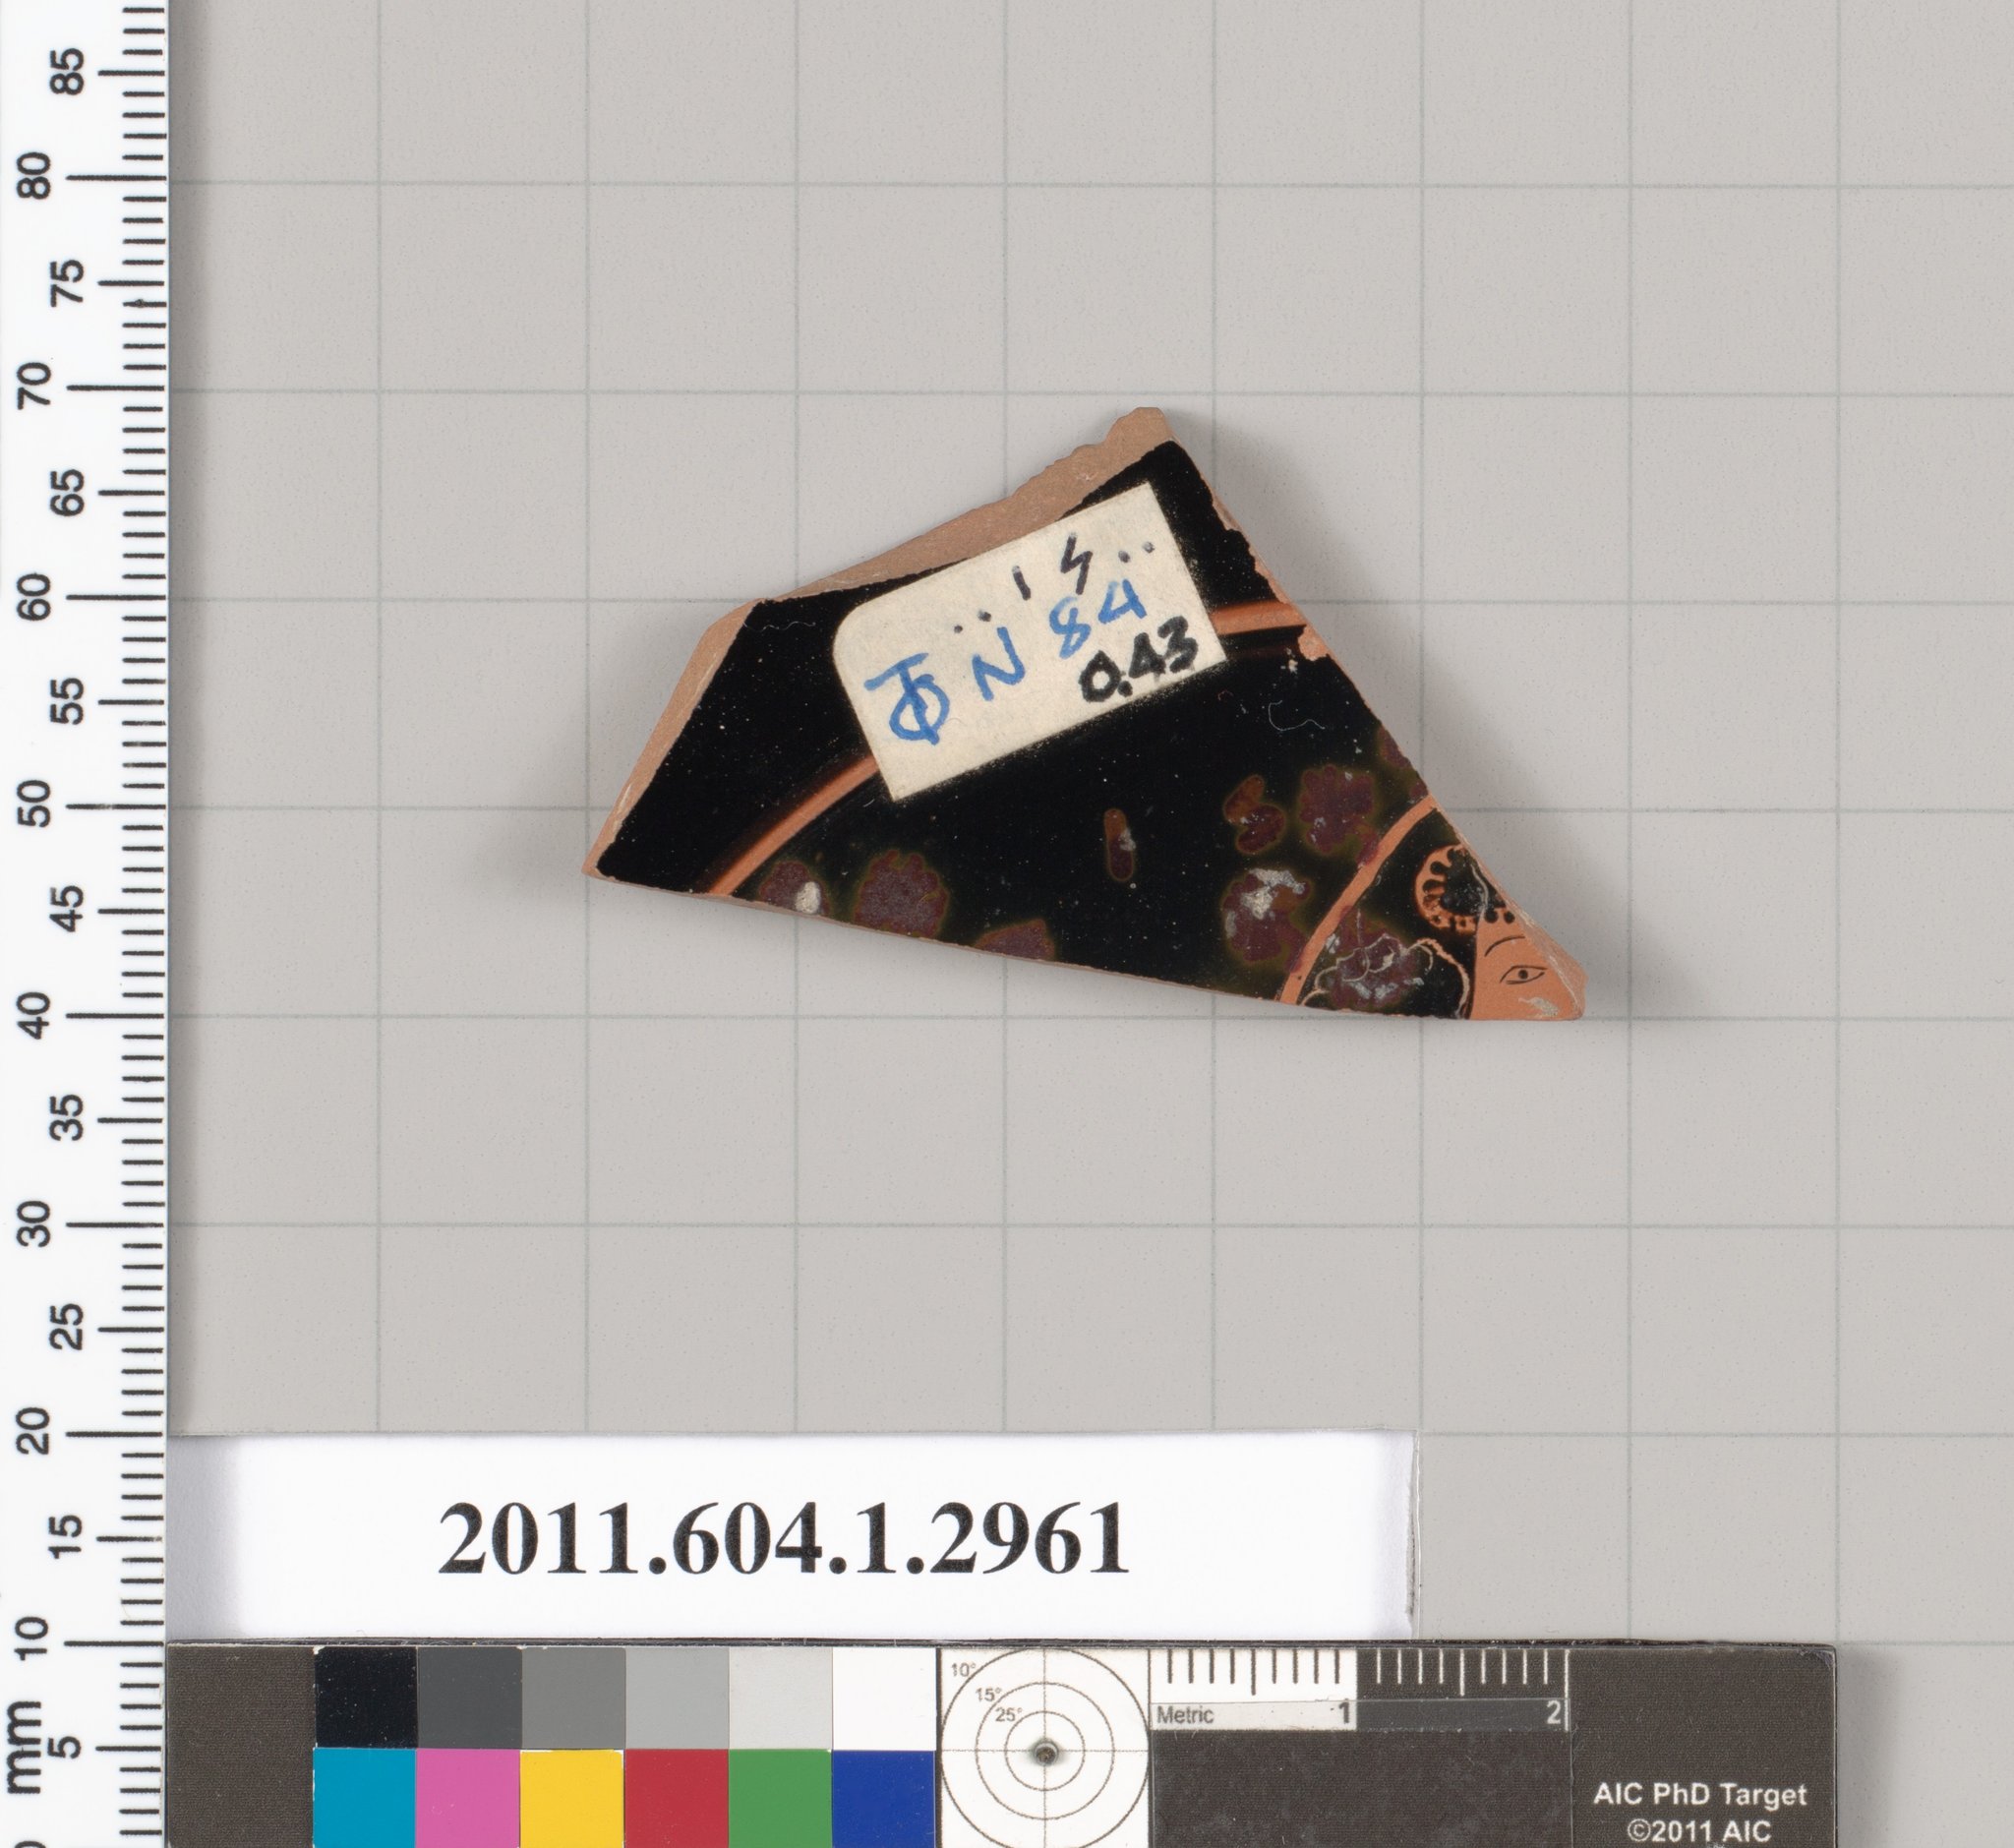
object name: kylix fragment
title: Terracotta fragment of a kylix (drinking cup)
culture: greek, attic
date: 520-500 BCE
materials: terracotta